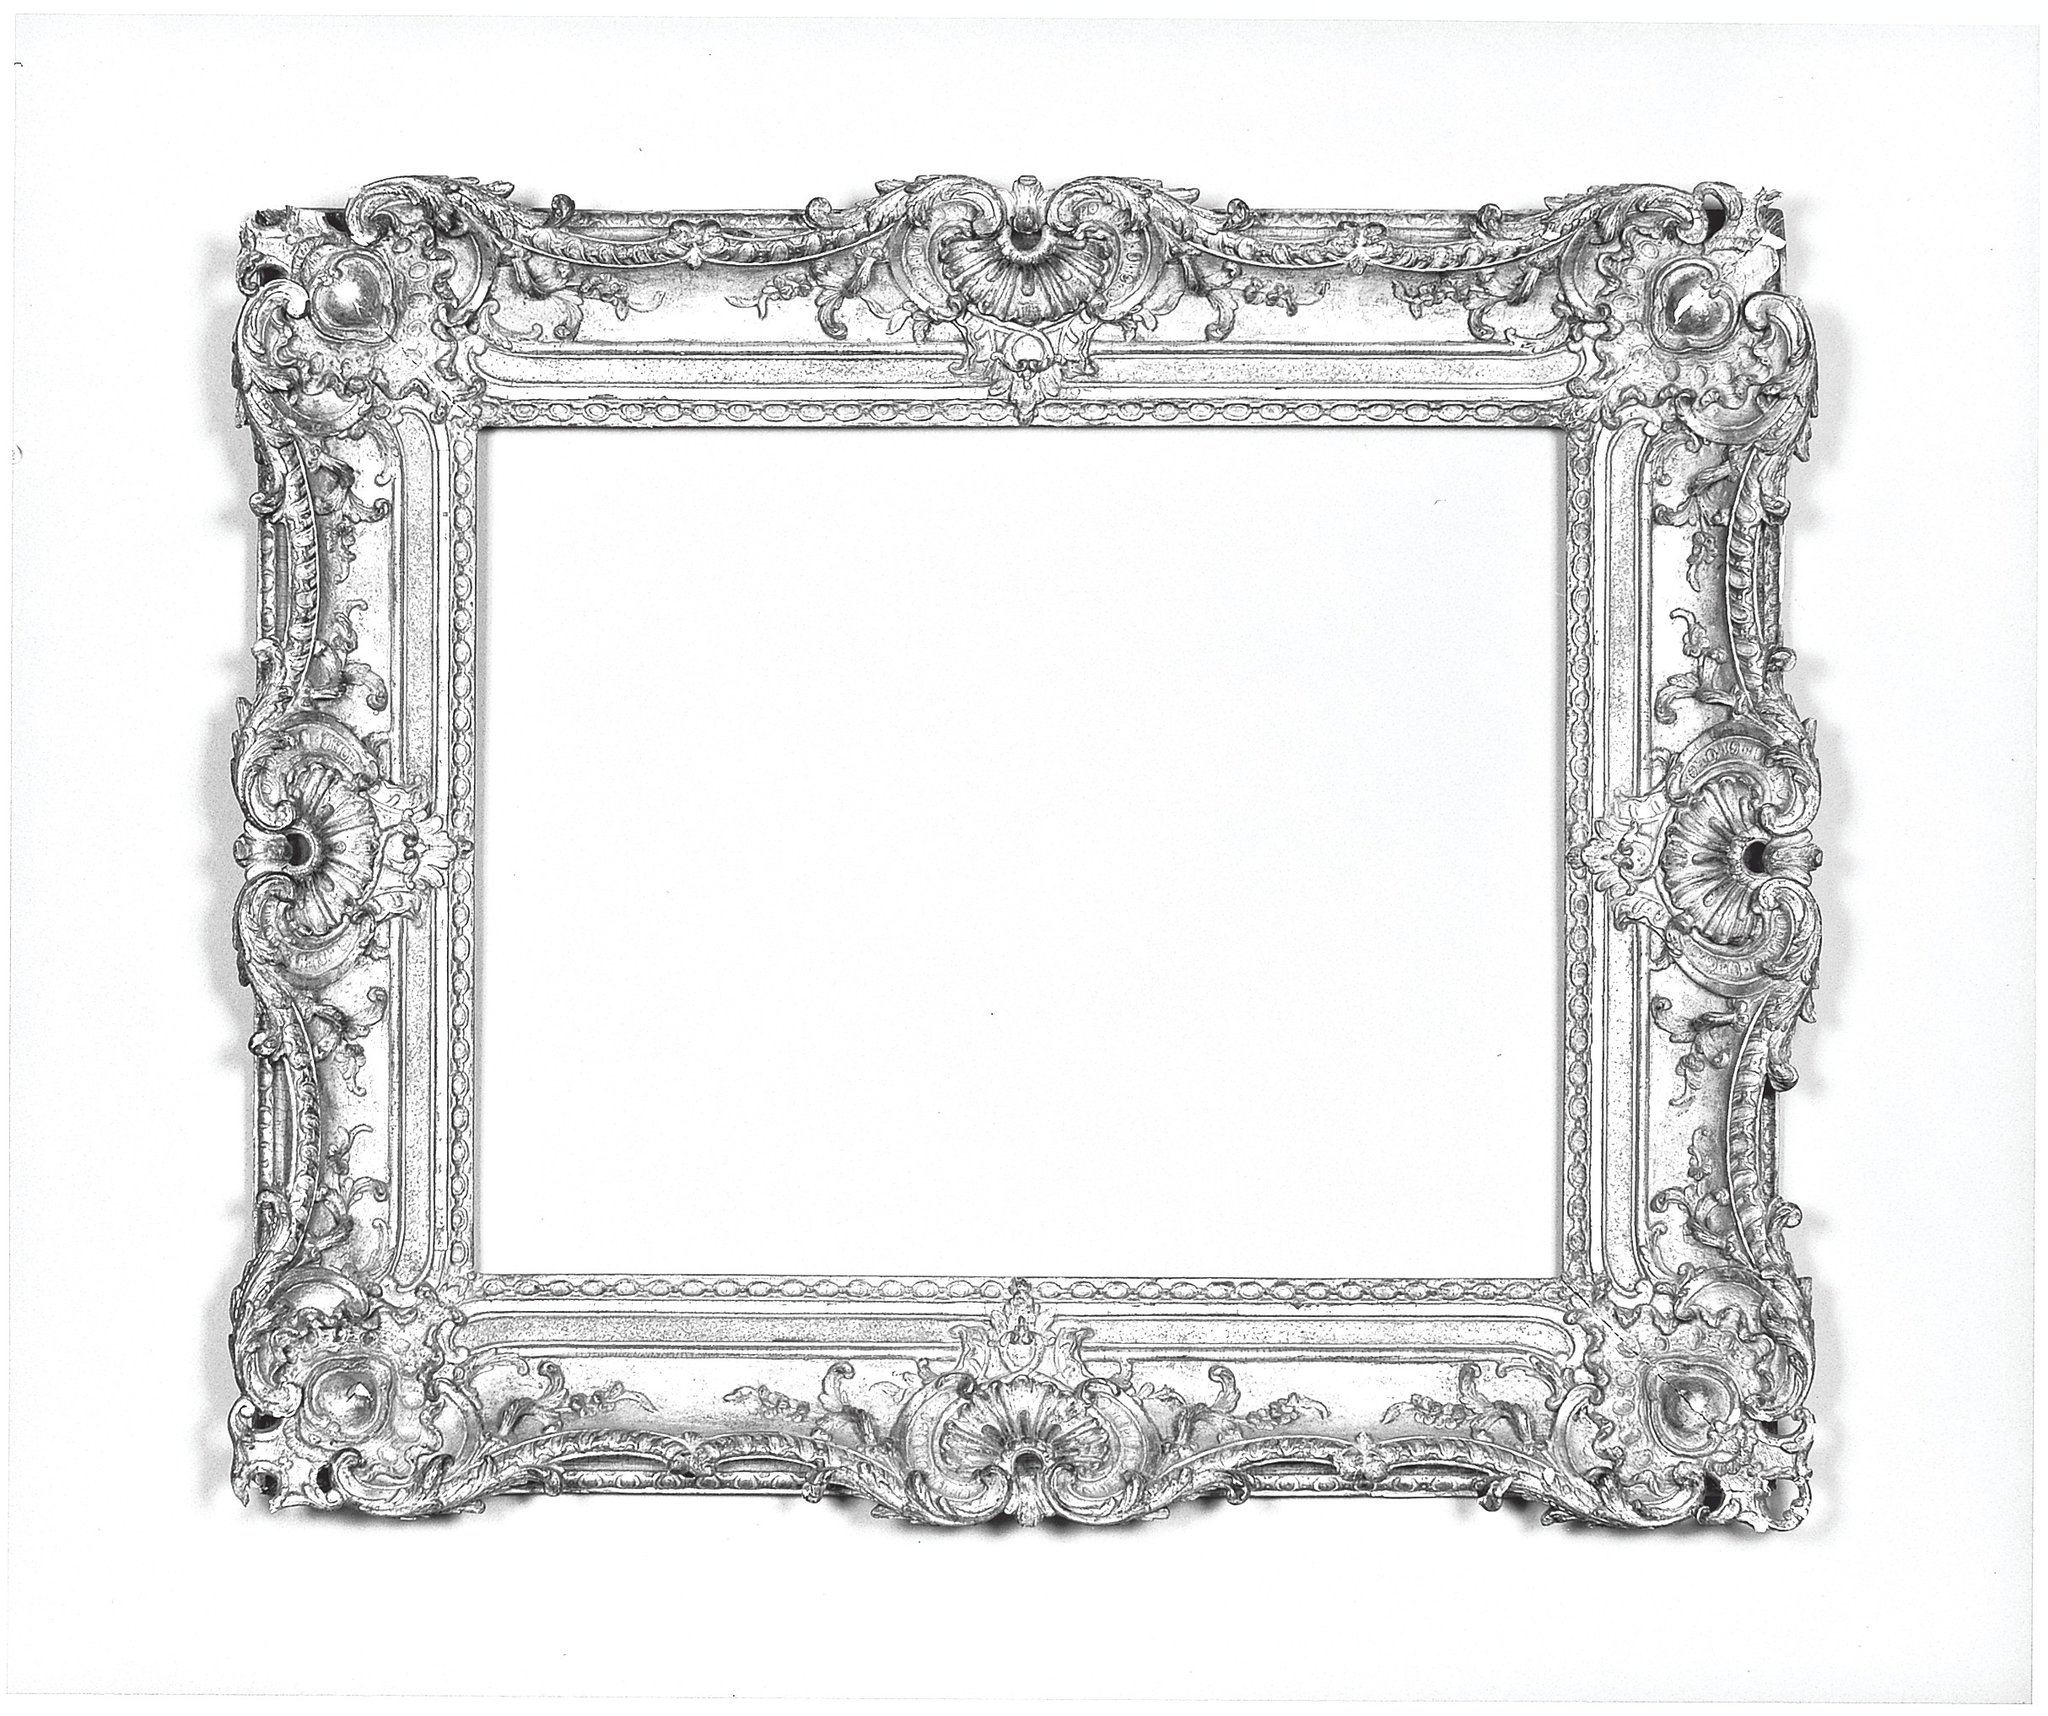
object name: frame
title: Swept frame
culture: german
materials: feather, wood